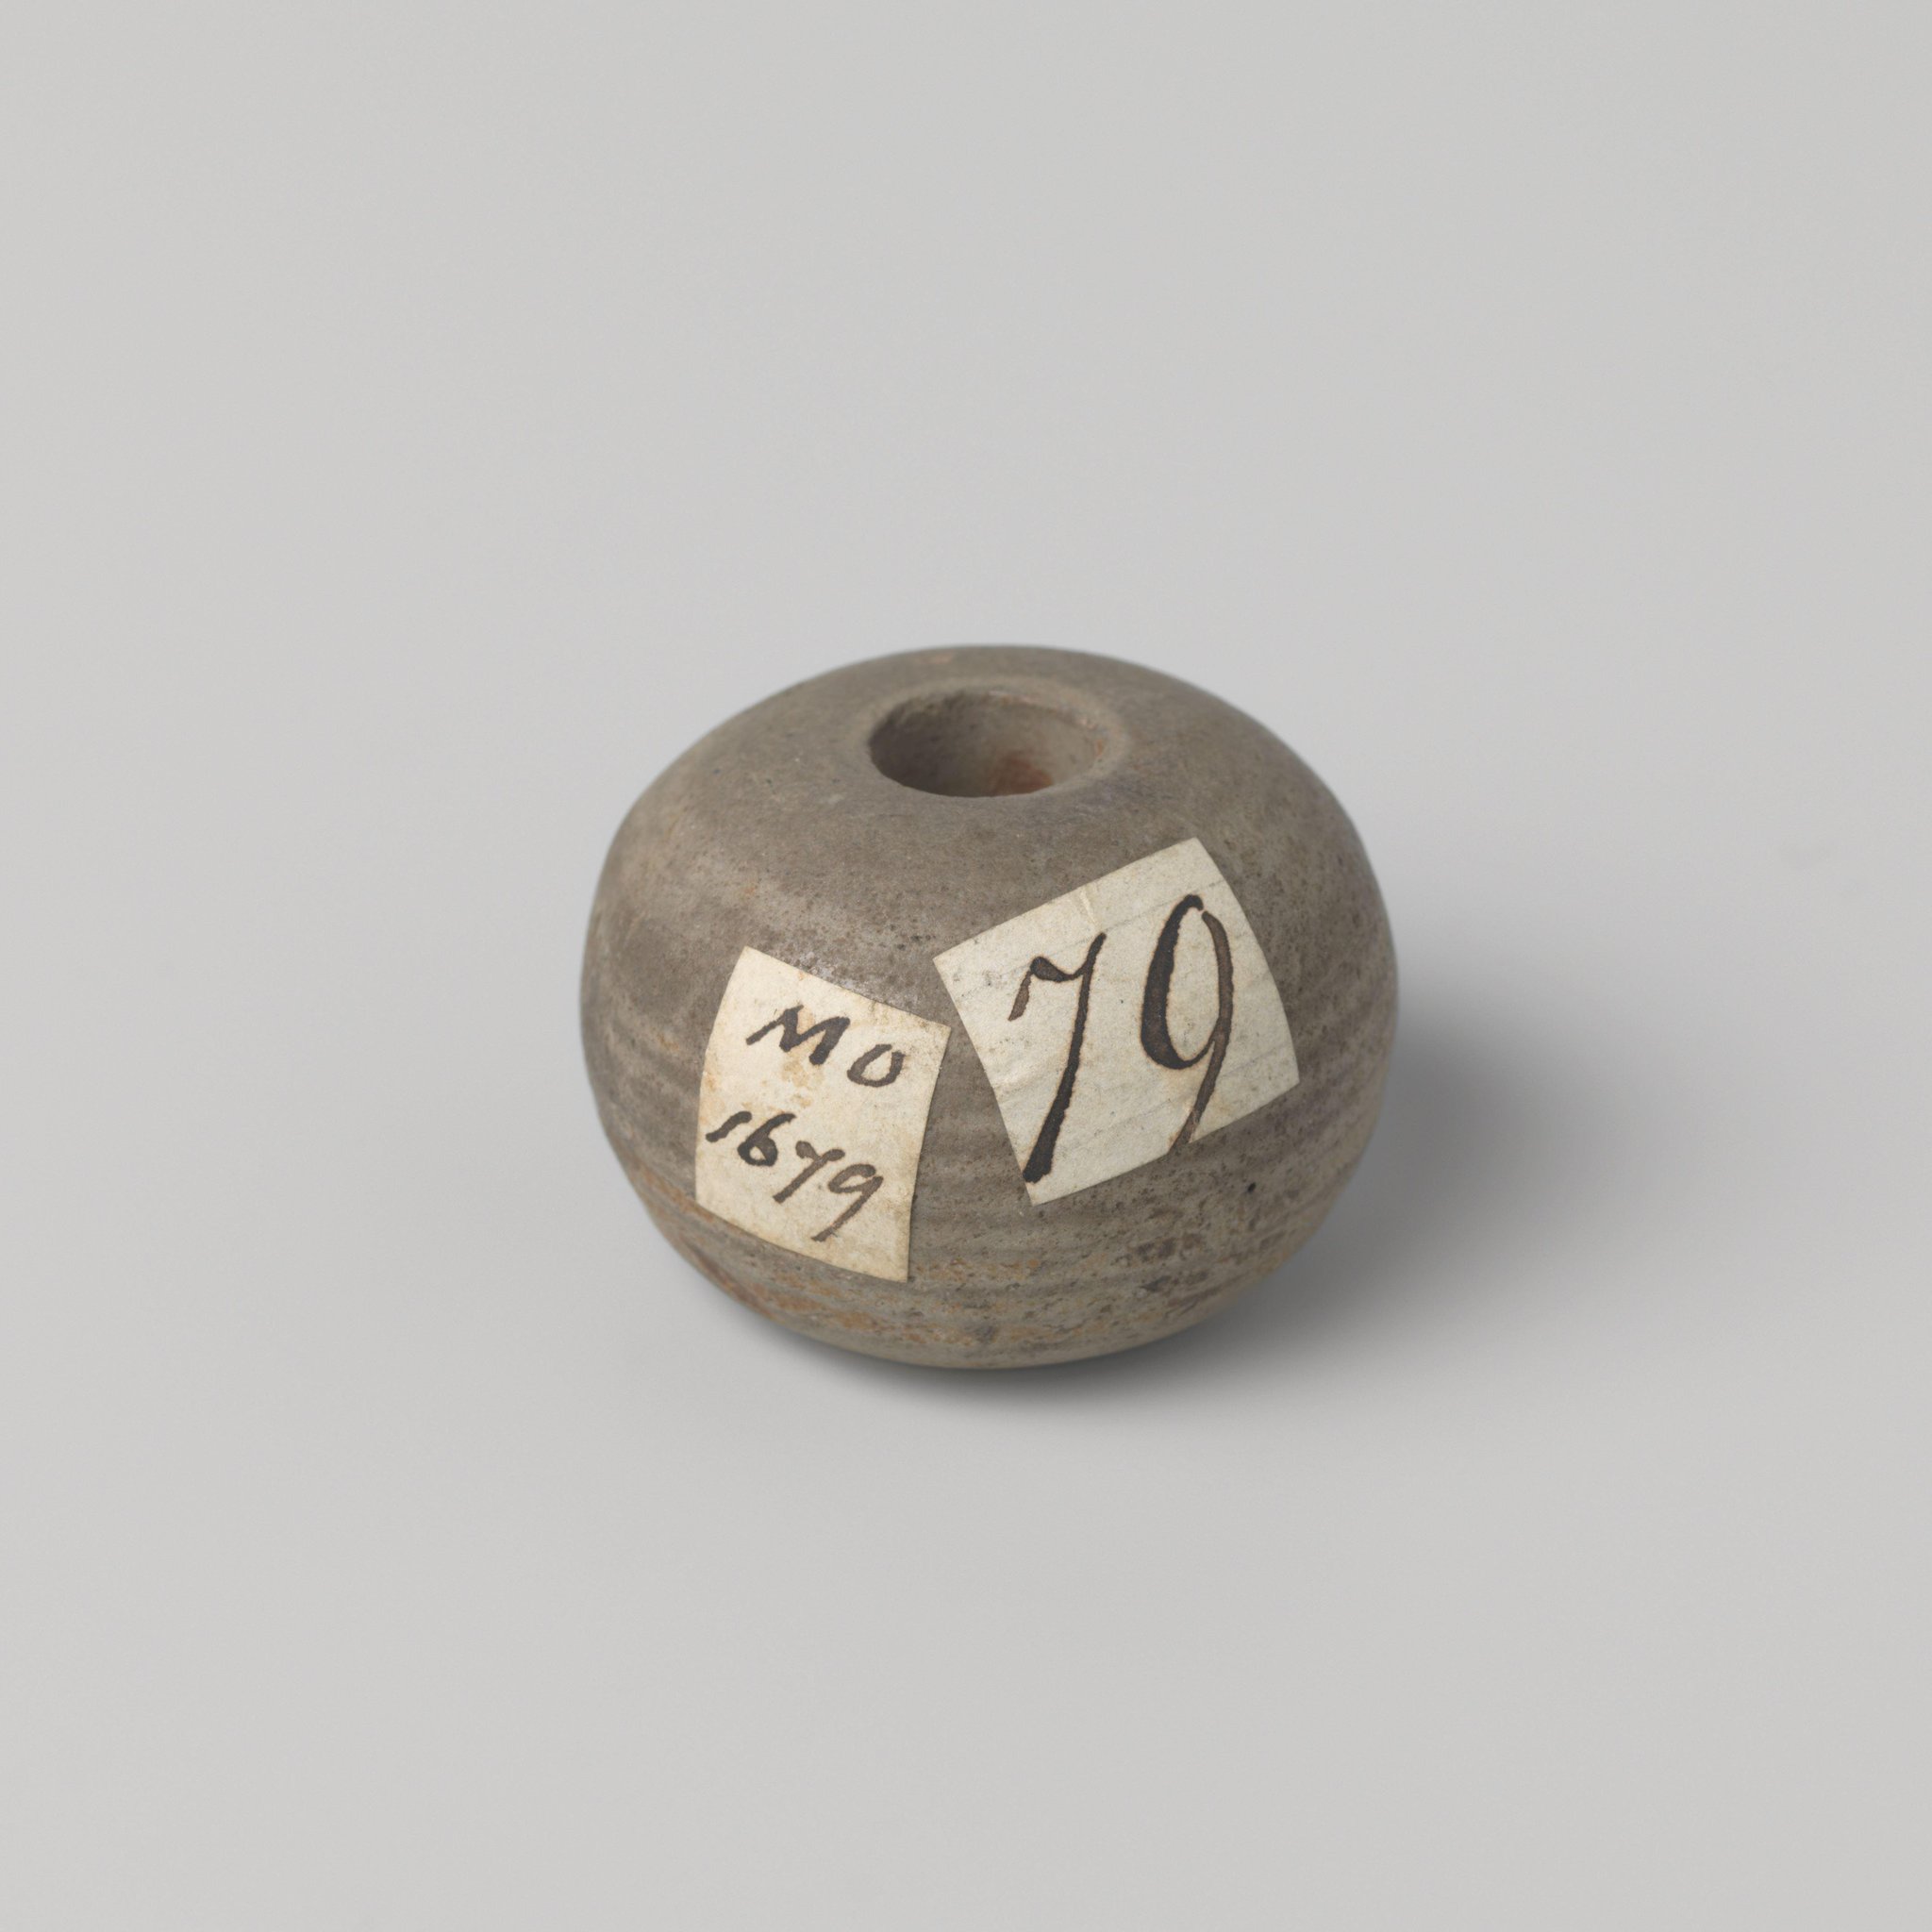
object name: spinsteen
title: Spinning stone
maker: Anonymous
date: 1600-1699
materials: glaze, stoneware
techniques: firing, turning, vitrification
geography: germany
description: Spinsteen van steengoed. Een band van ingegrifte lijnen op het breedste deel van de steen.